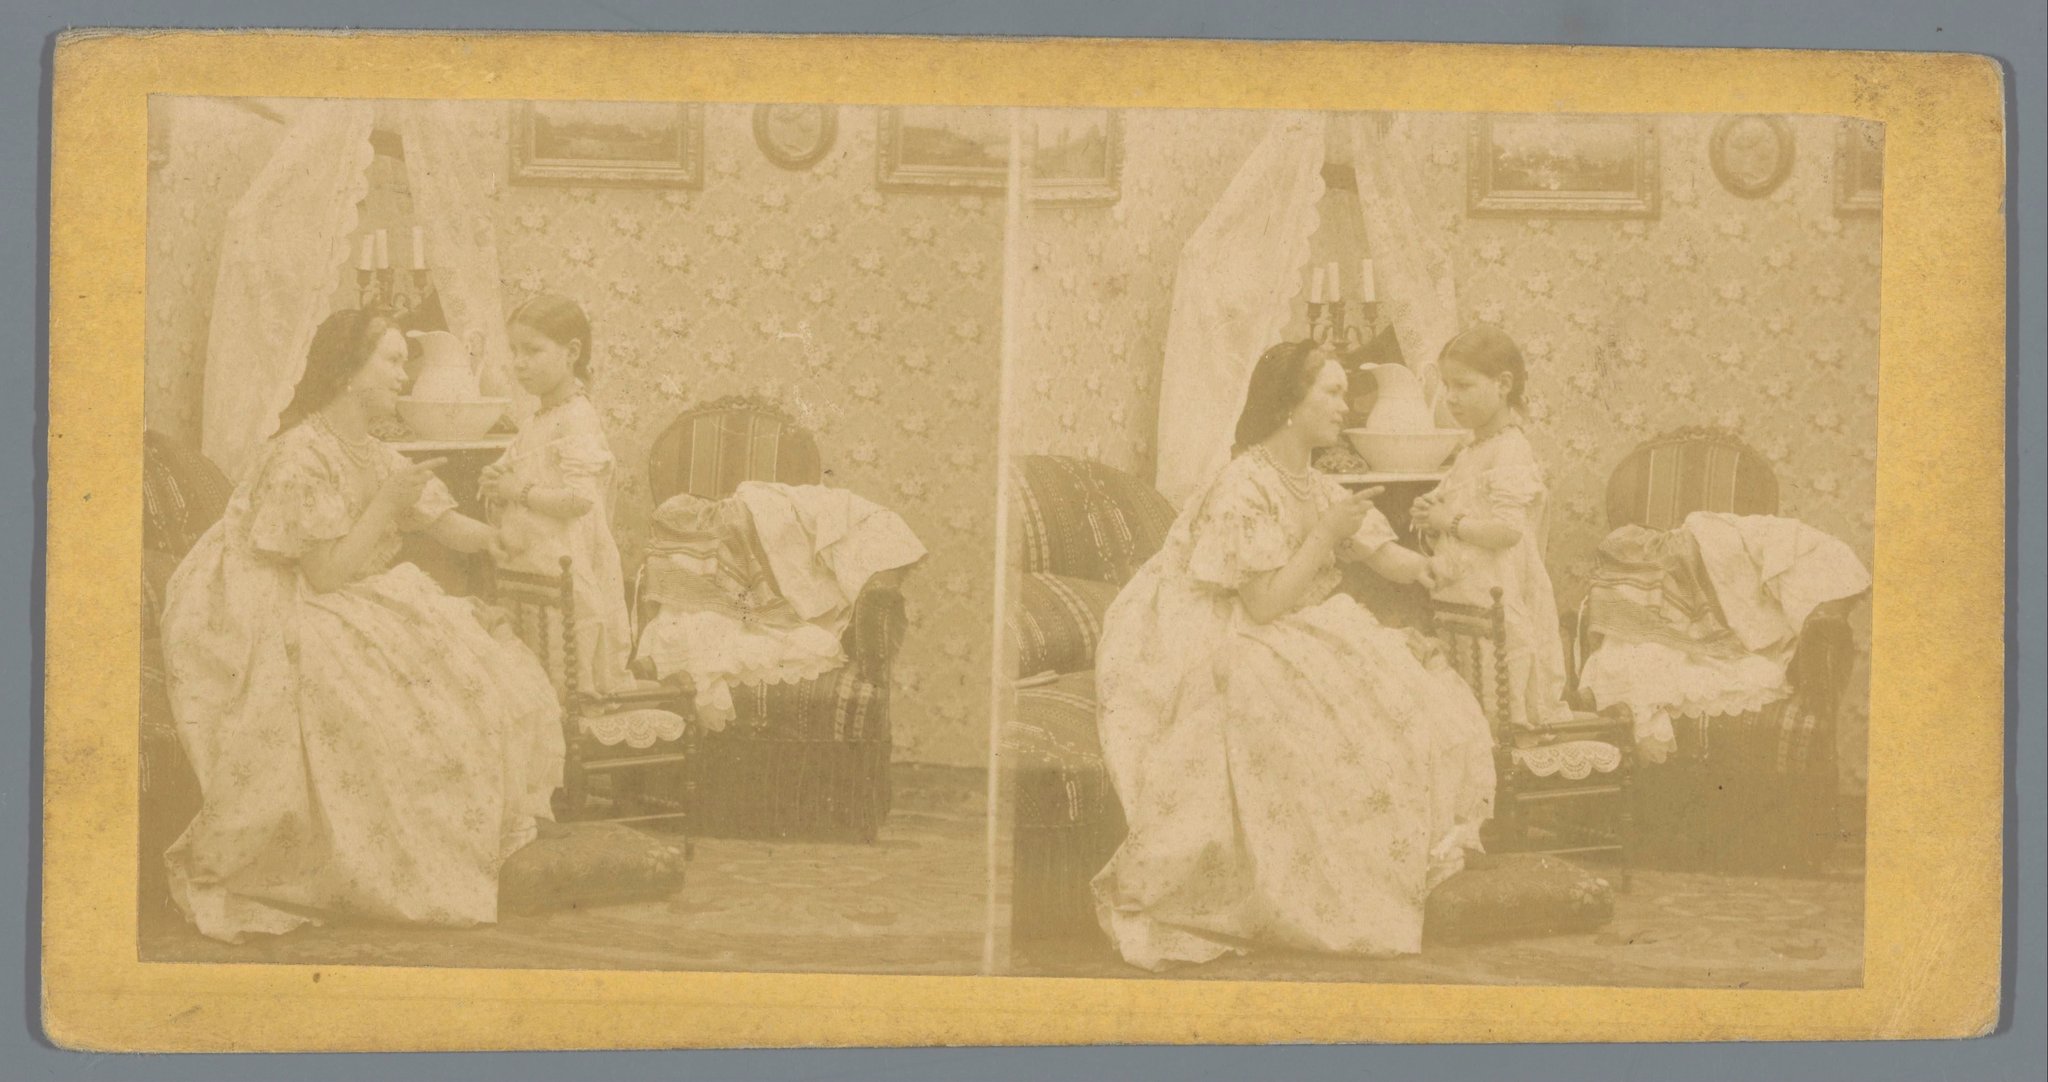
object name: stereograph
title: Vrouw met een biddend meisje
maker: Anonymous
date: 1850-1870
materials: cardboard, photographic support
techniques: albumen print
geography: europe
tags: mother and baby or young child, one person praying, europe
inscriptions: number: ‘92’